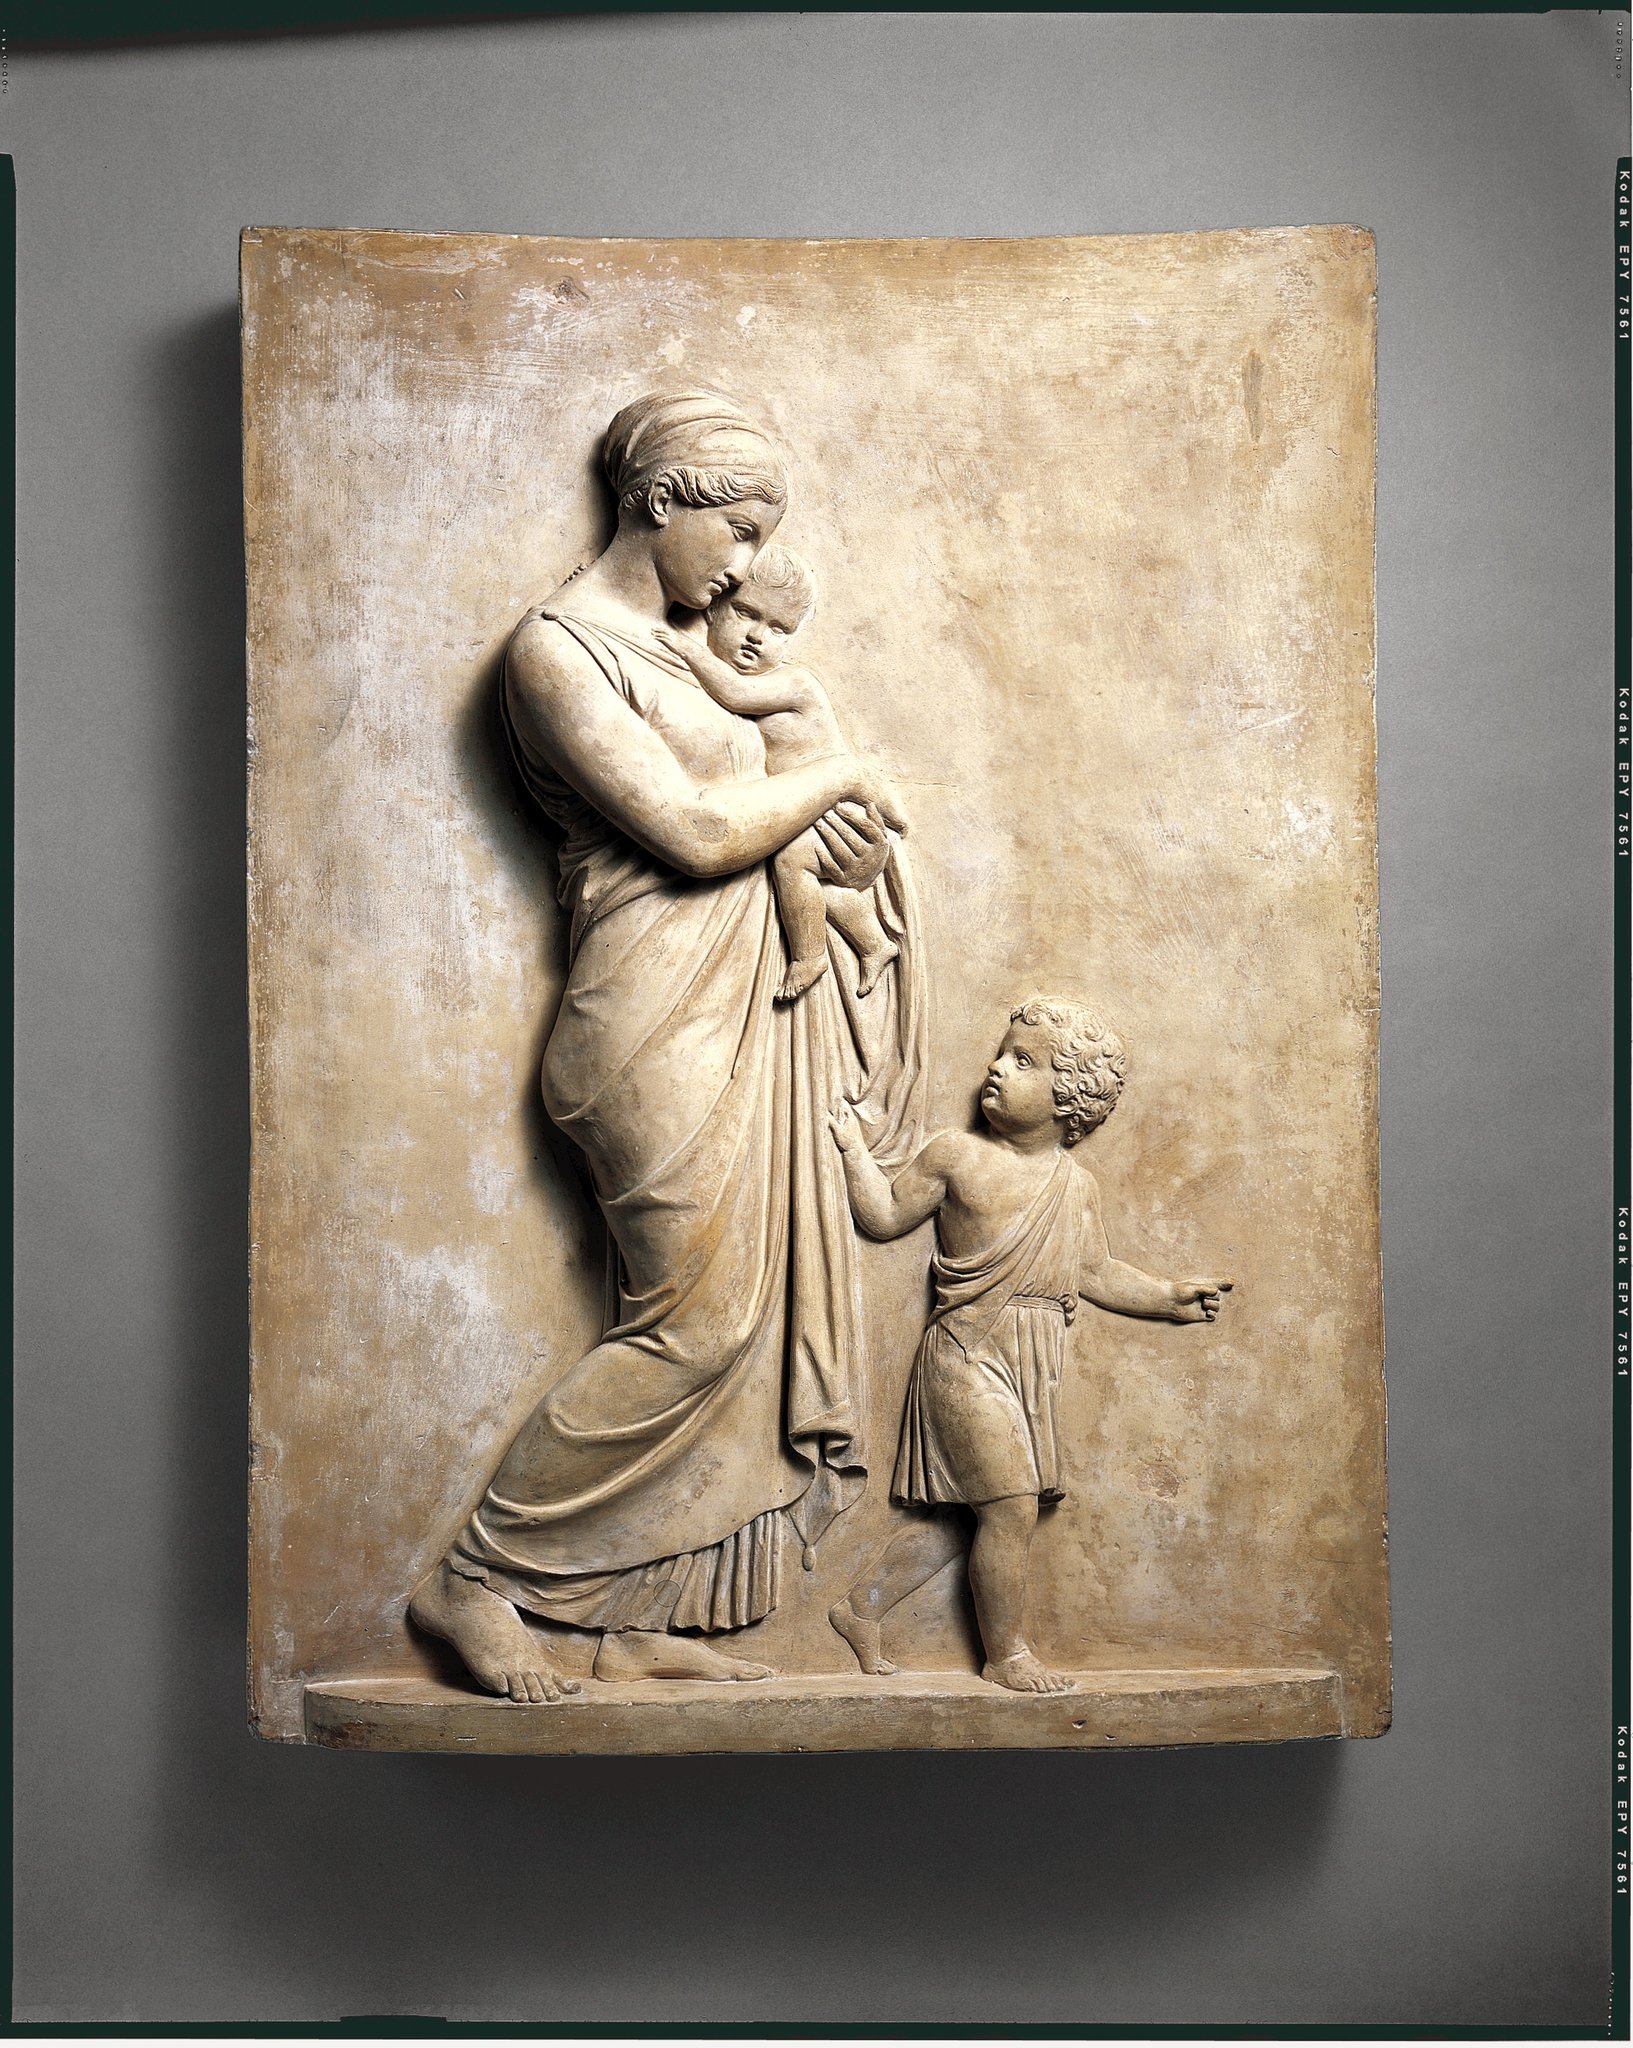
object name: relief model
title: Christian Charity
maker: bertel thorvaldsen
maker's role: artist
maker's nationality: danish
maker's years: 1770-1844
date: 1801-1900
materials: terracotta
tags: children,women